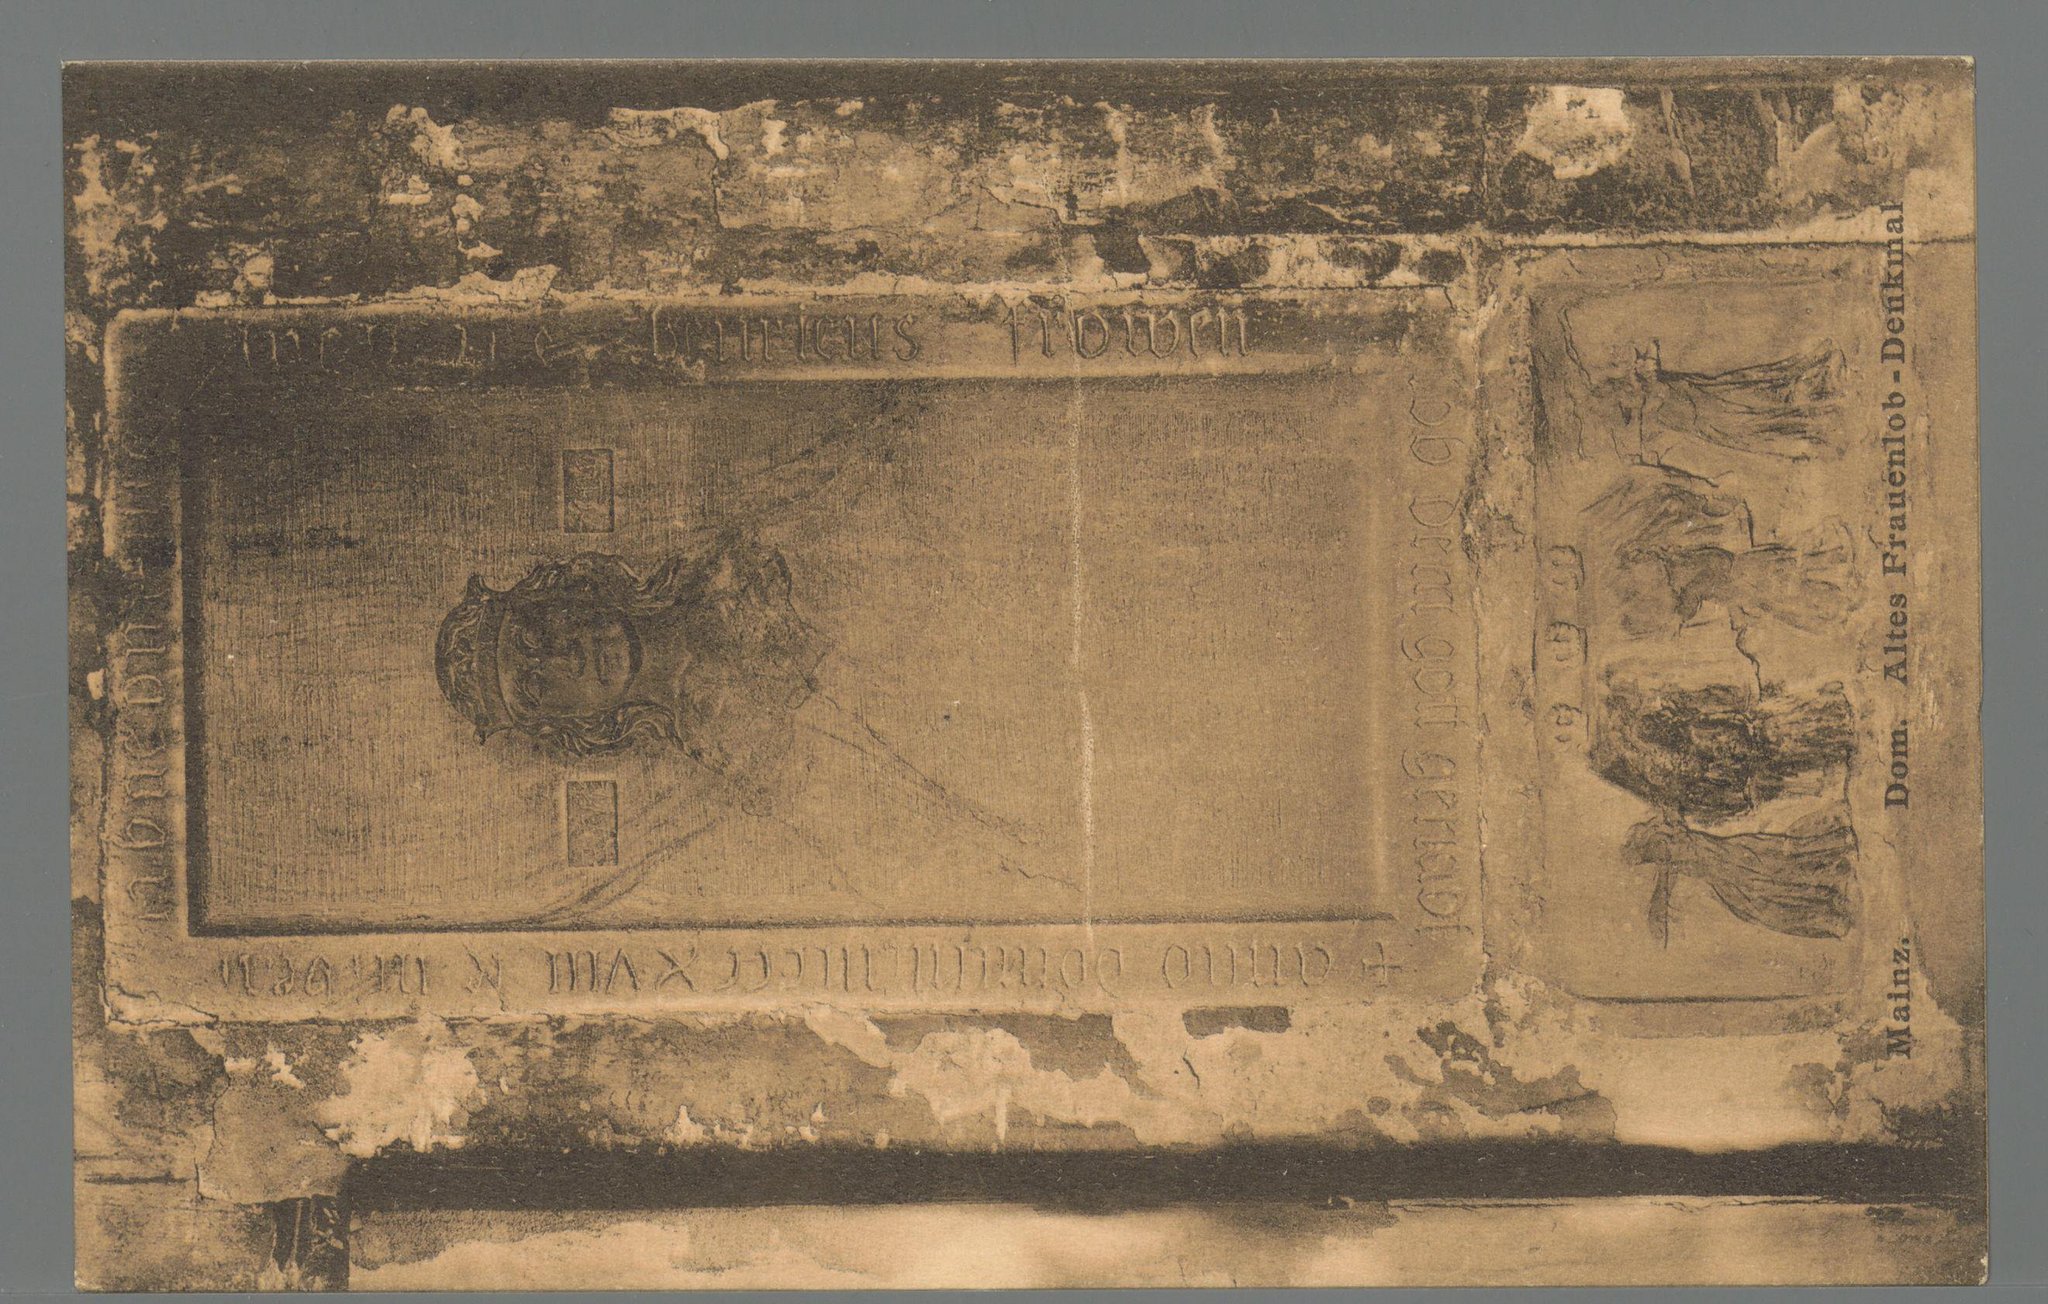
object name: photomechanical print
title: Mainz. Dom. Altes Frauenlob - Denkmal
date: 1906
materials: cardboard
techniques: photograph, writing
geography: magdeburg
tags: interior of church, monument, statue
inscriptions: date